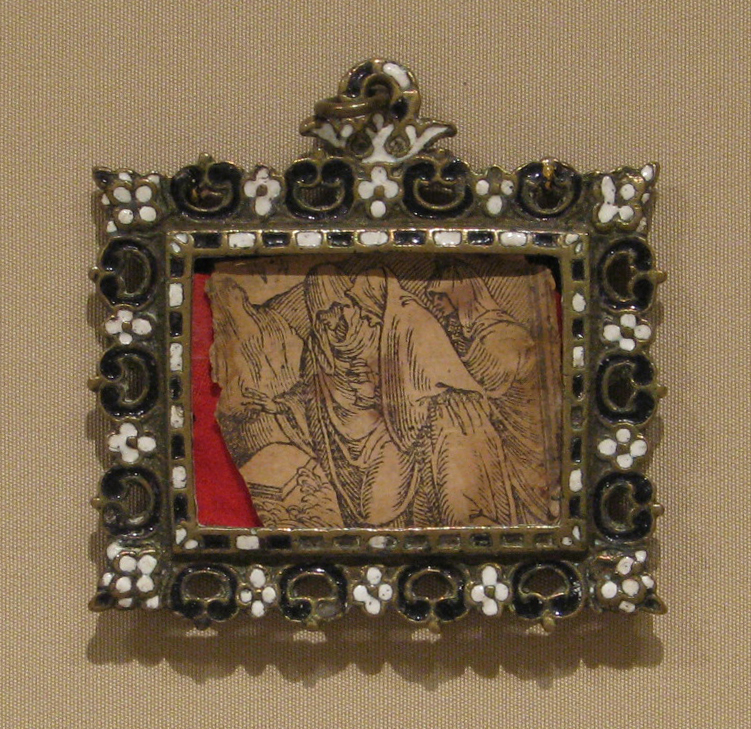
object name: pilgrim's badge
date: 1601-1650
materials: brass, enamel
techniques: enamel, gilding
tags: women